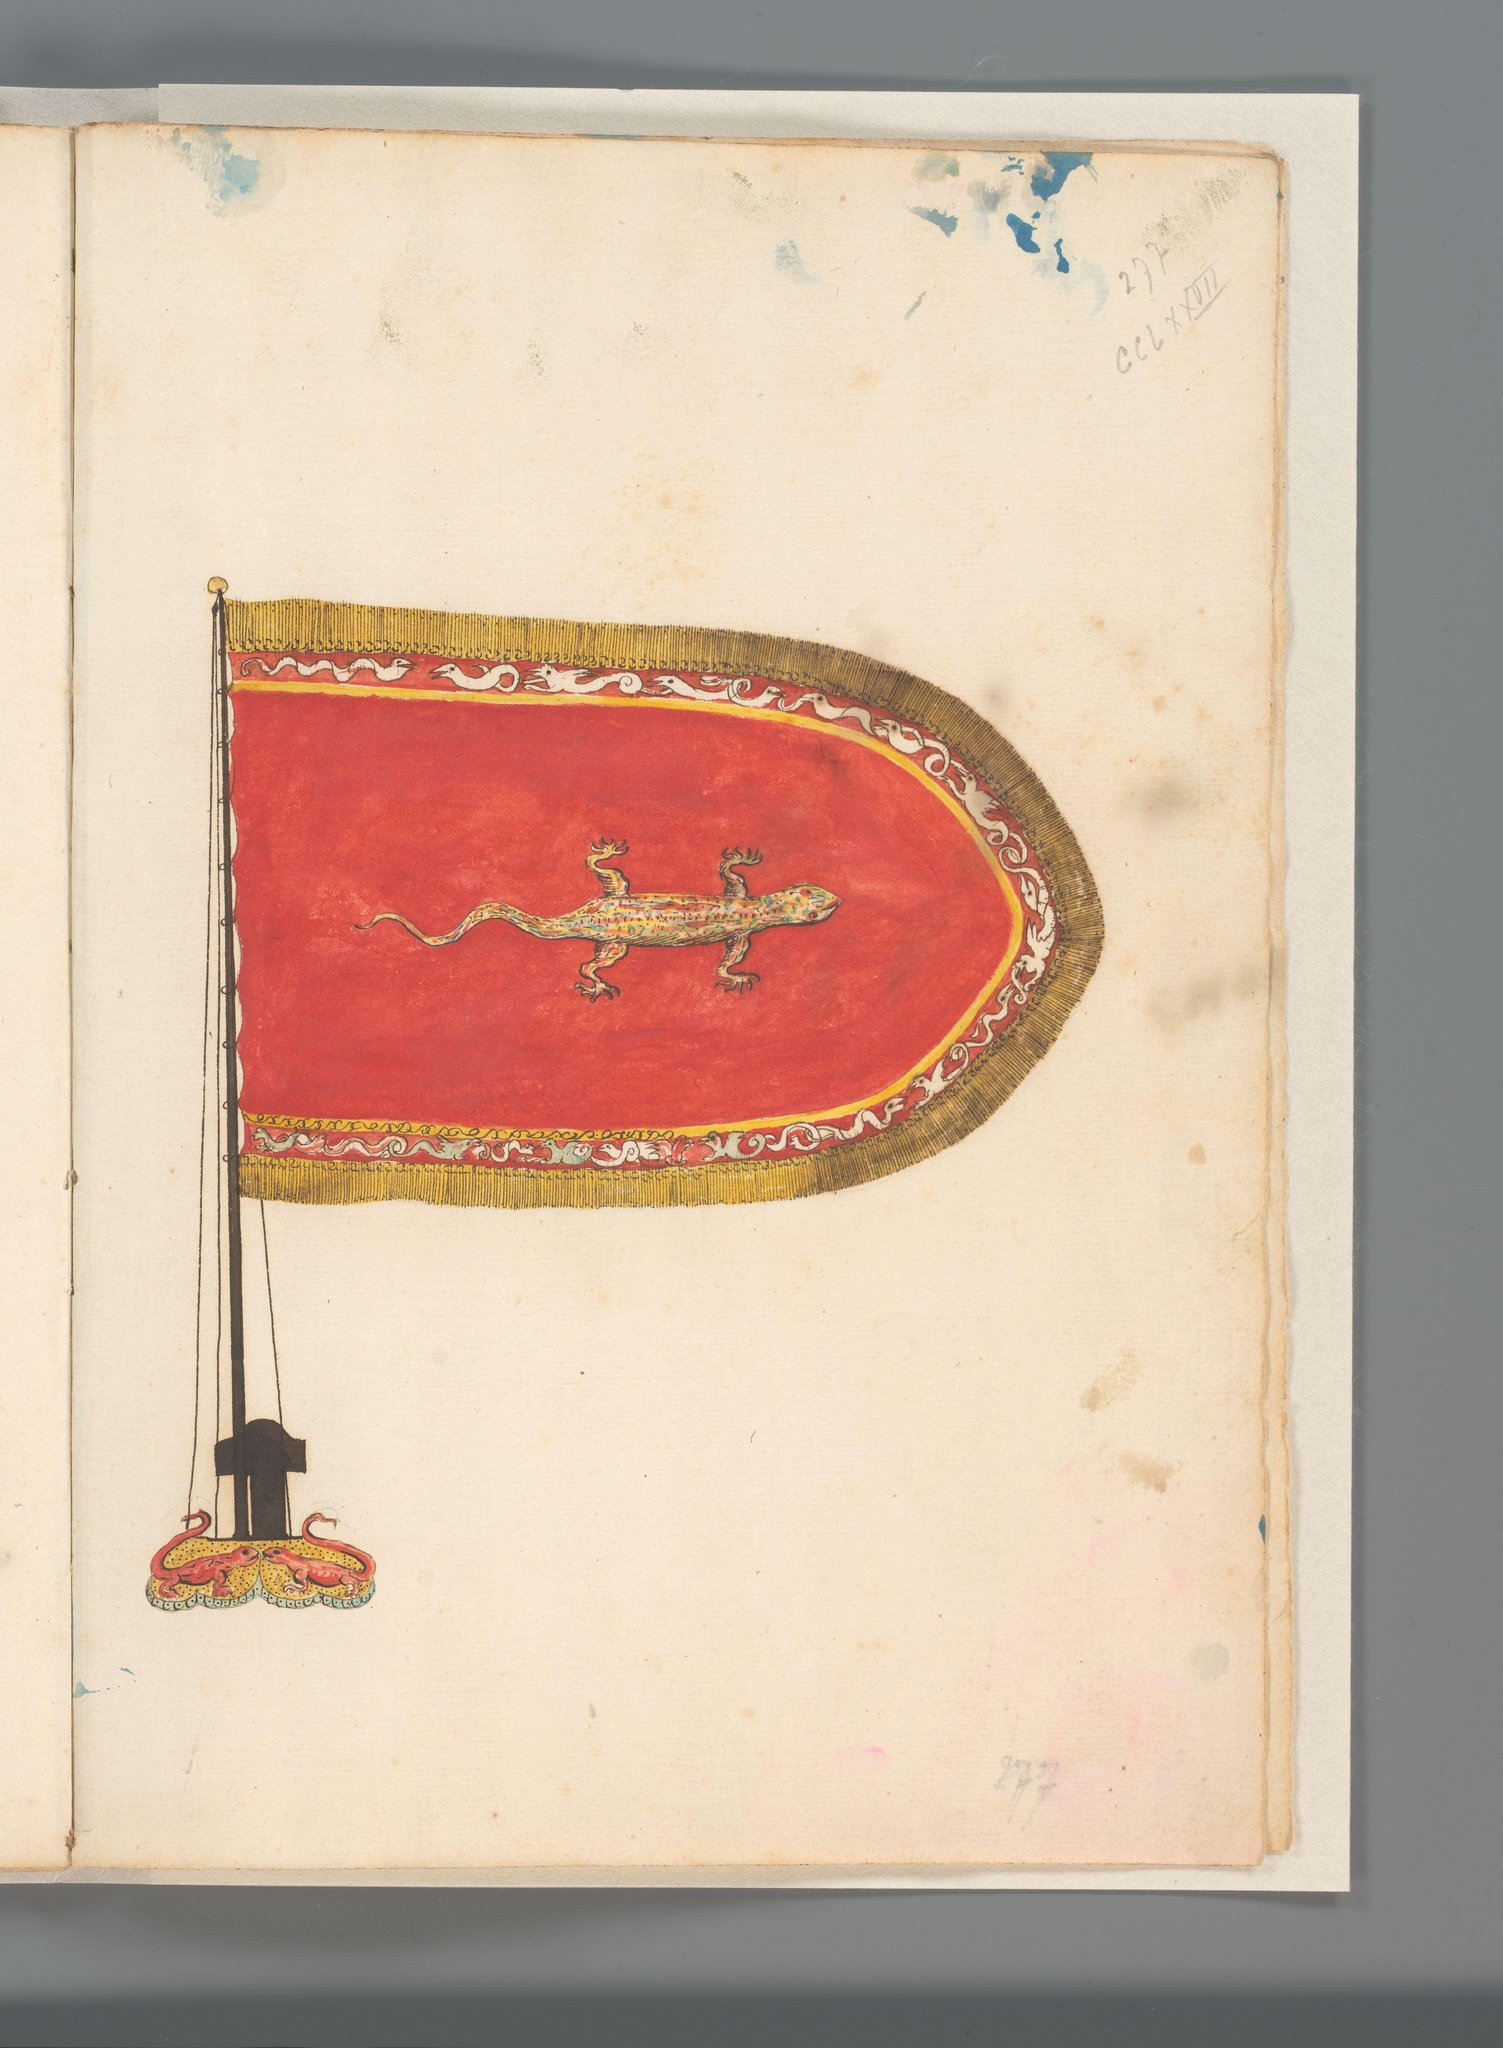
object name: drawing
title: Vlag van een islamitisch land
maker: Anonymous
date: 1667-1670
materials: ink, paper, watercolor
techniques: brush, pen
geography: france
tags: flag, colours (as symbol of the state, etc.)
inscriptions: number: ‘277 / CCLXXVII / 277’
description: Vlag van een onbekend islamitisch land. Rode vlag waarop een salamander of hagedis, met een decoratieve geborduurde rand met franje, met afgeronde vluchtzijde. Vlag op vlaggensteng en mastvoet. Afgebeeld op folio 139r. Onderdeel van een vlaggenboek met vlaggen uit Europa, Noord-Afrika, Nabije en Verre Oosten.